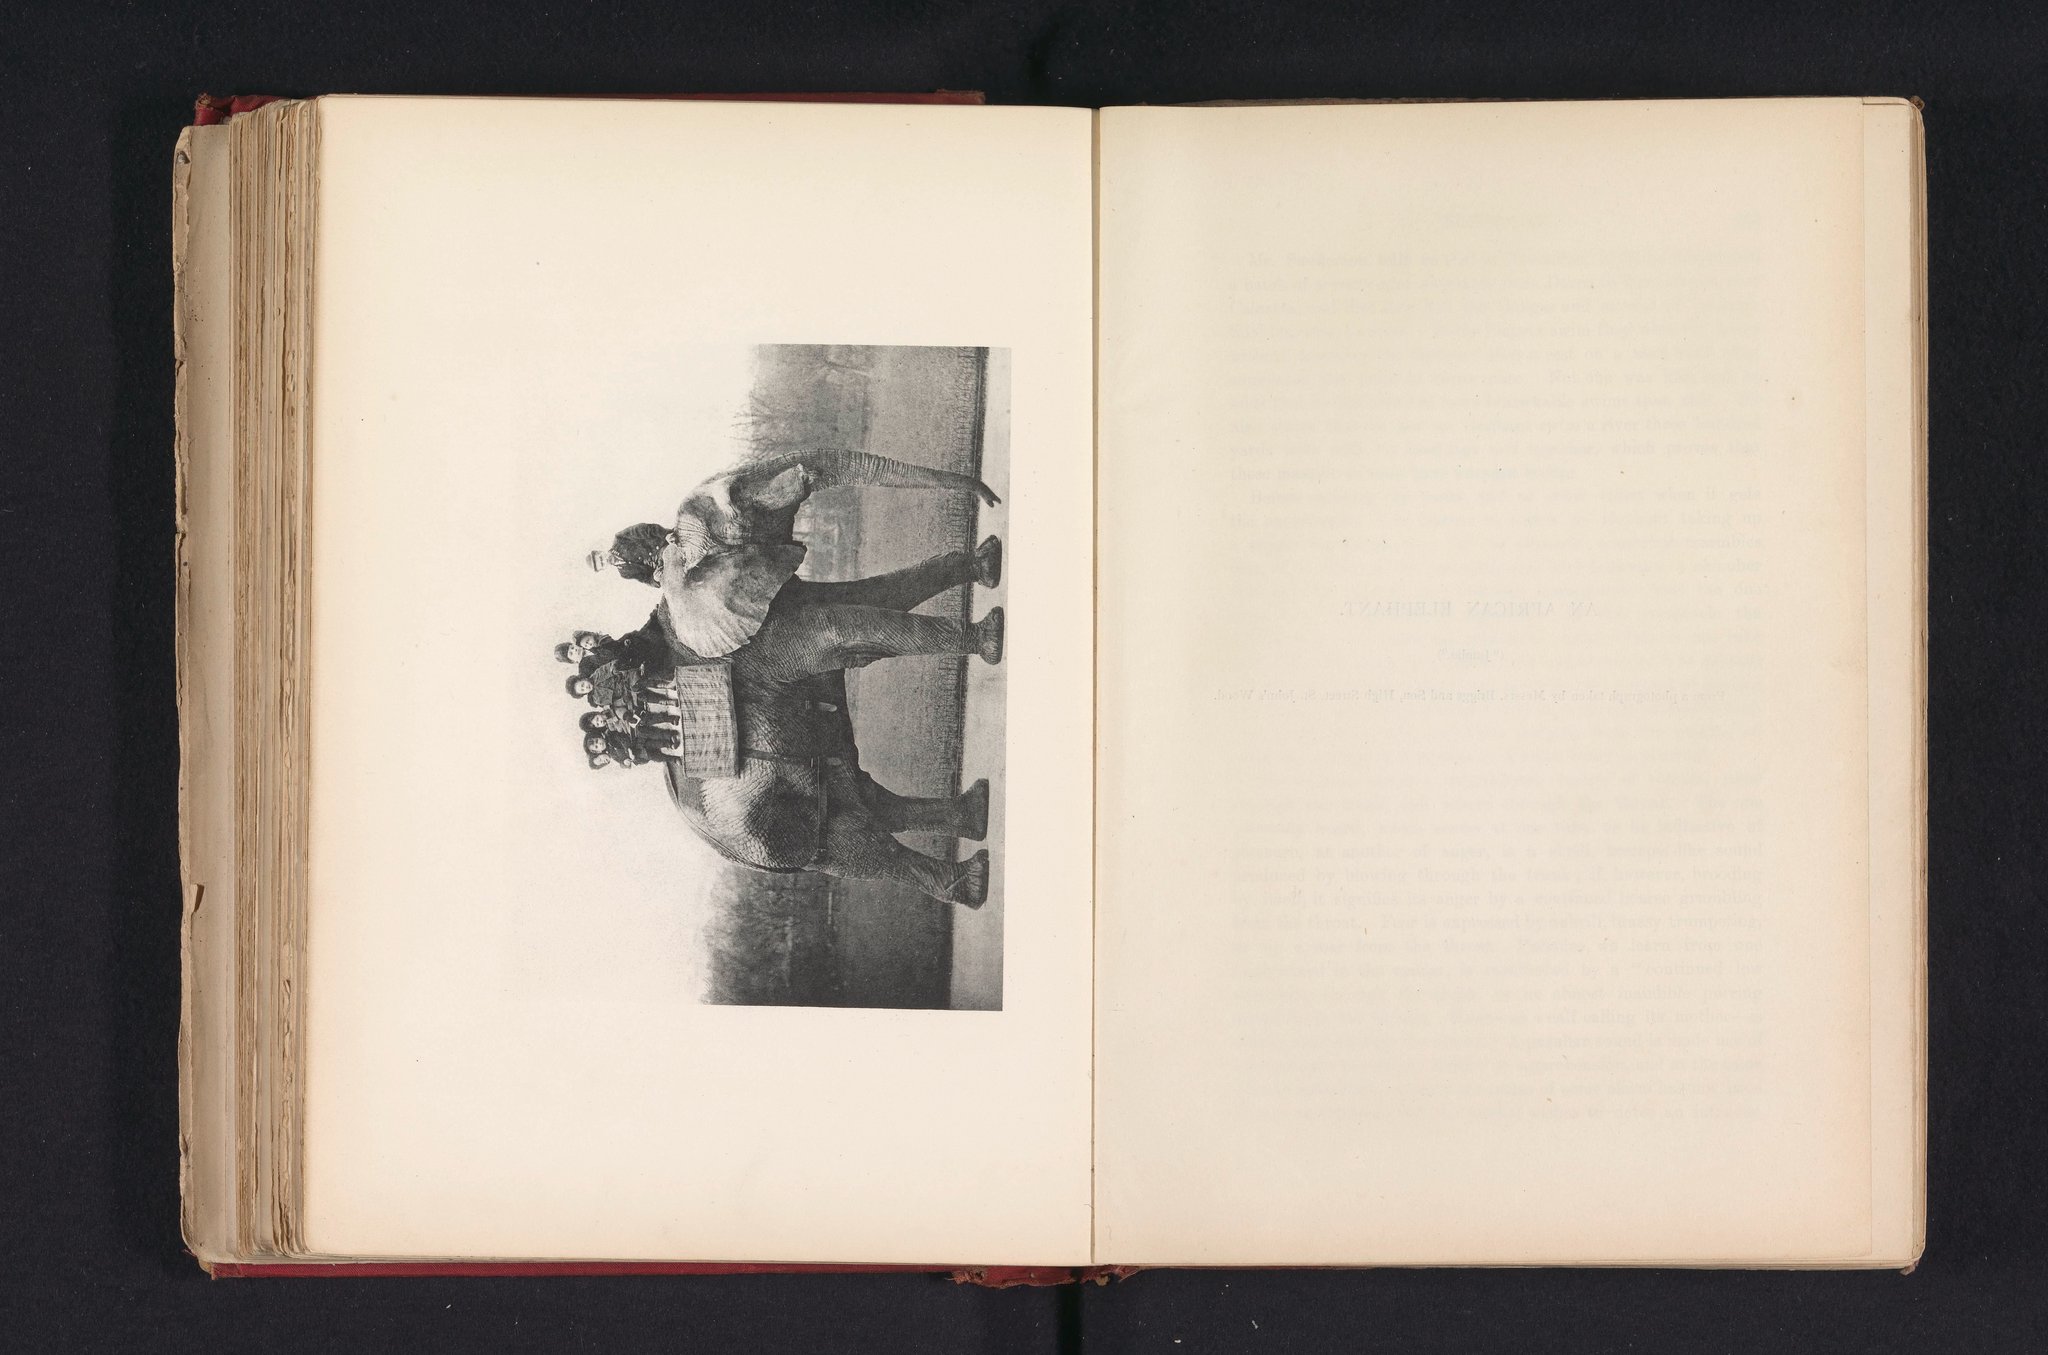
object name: page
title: An African elephant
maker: Anonymous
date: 1876-1886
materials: paper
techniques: photograph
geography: paris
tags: trunked animals: elephant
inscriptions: inscription: ‘From a photograph taken by Messrs. Briggs and Son, High Street, St John's Wood.’